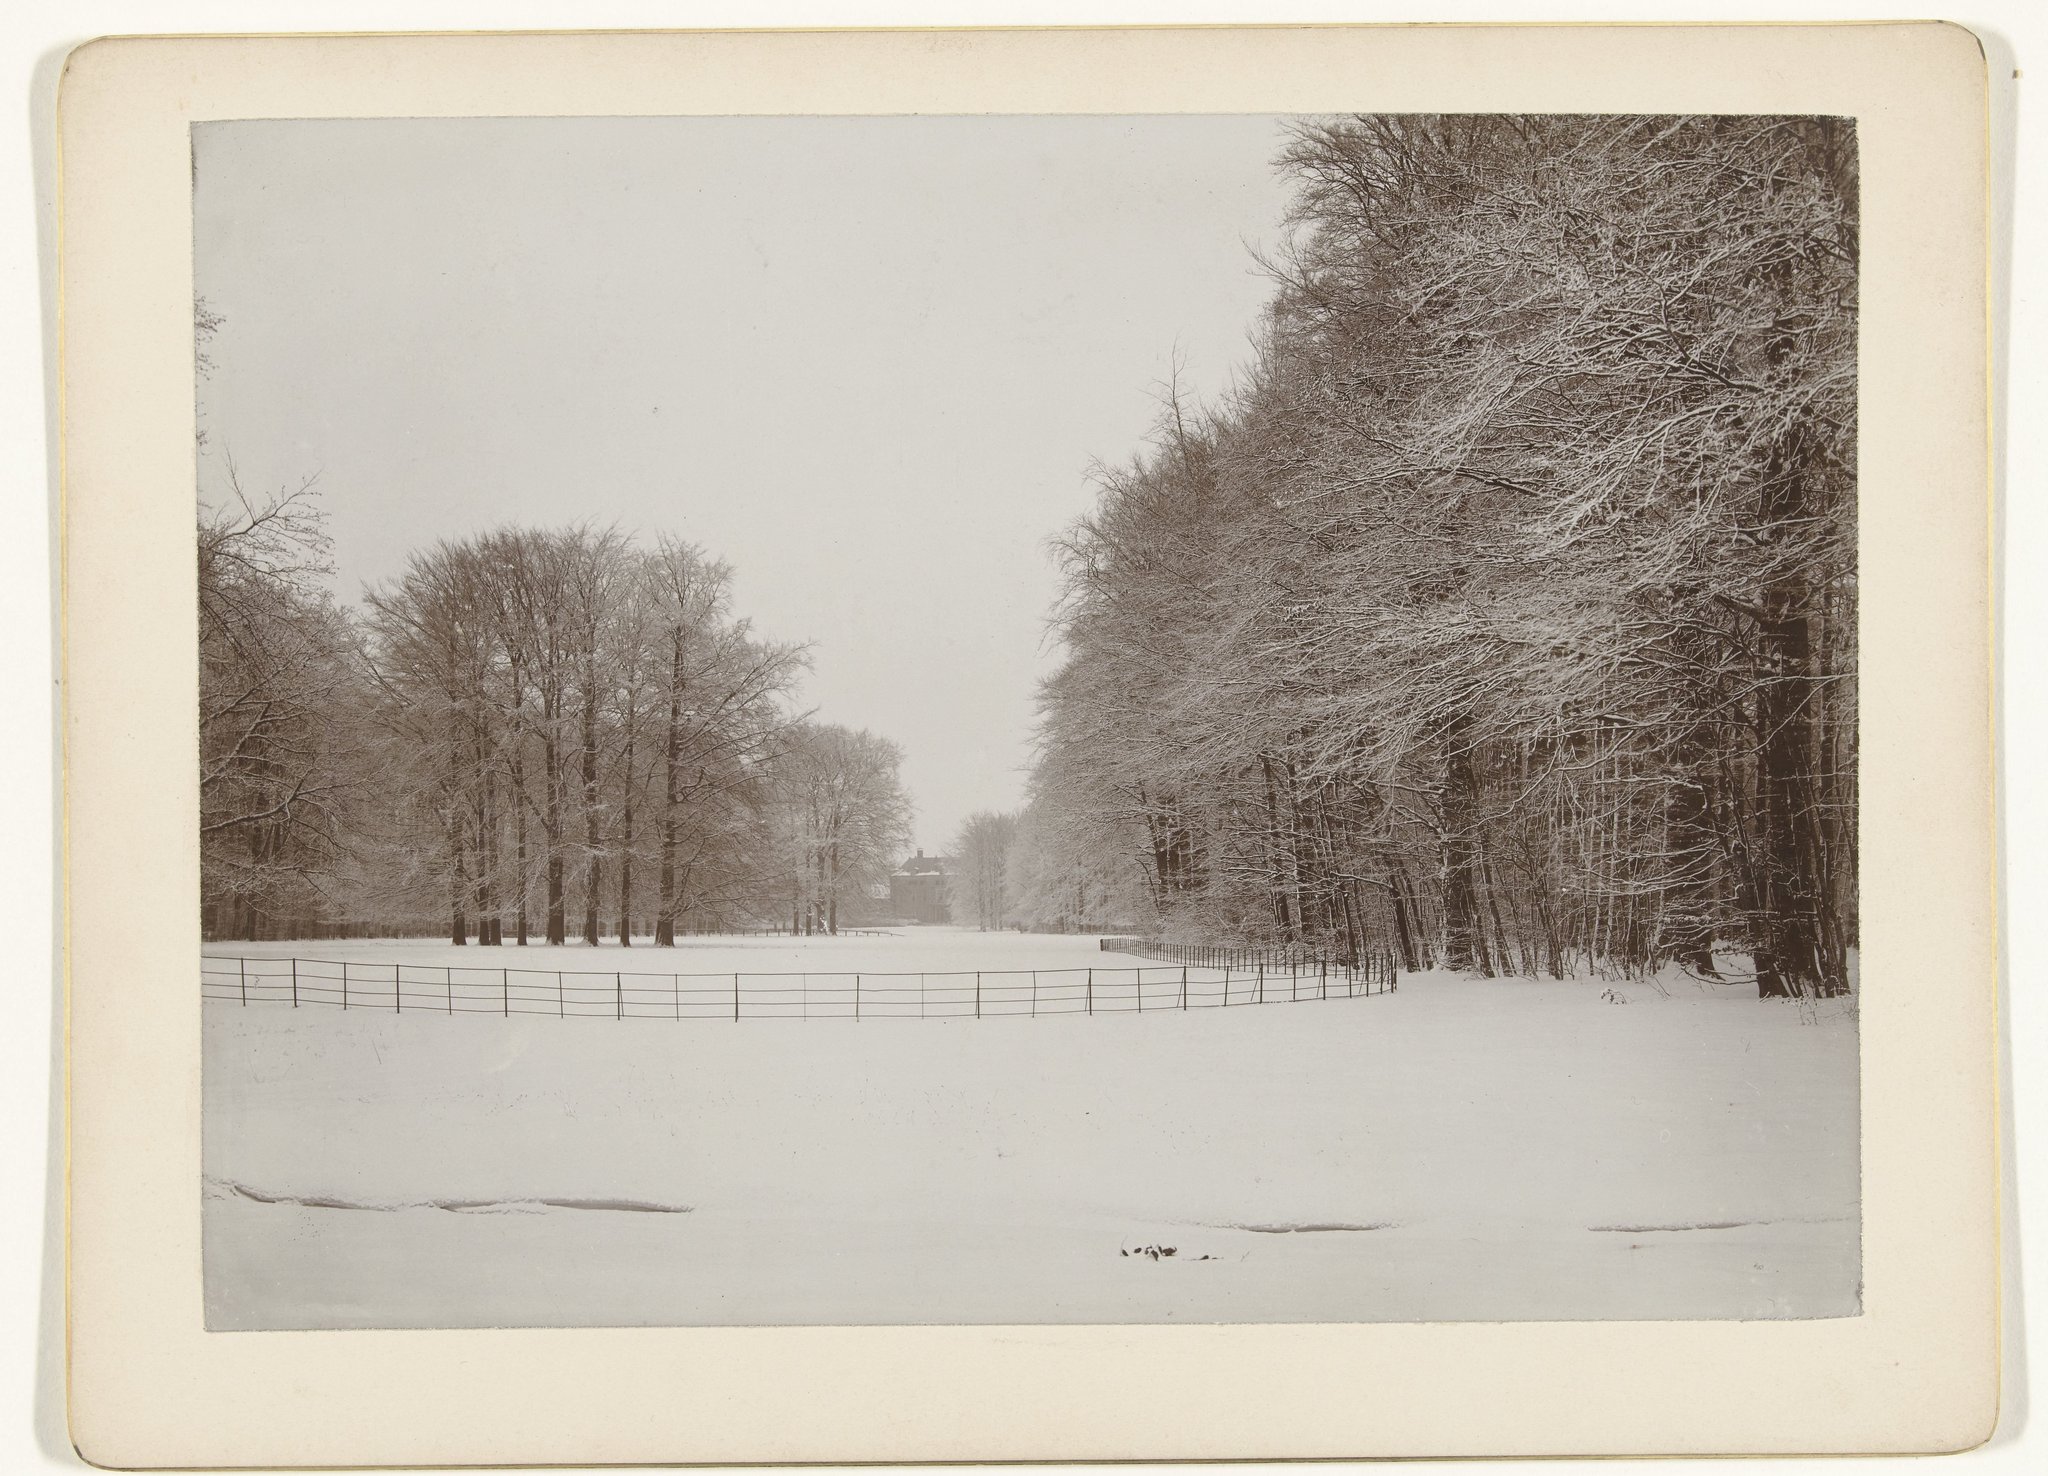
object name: photograph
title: Besneeuwd park met op de achtergrond een landhuis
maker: henry pauw van wieldrecht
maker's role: fotograaf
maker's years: 1863-1912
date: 1897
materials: cardboard, photographic support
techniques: gelatin silver print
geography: netherlands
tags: slot zeist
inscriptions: annotation: ‘No 1311.’, signature and date: ‘H. Pauw v. Wieldecht / photogr. 30 jan 1896 [in pen doorgehaald voor 7.].’